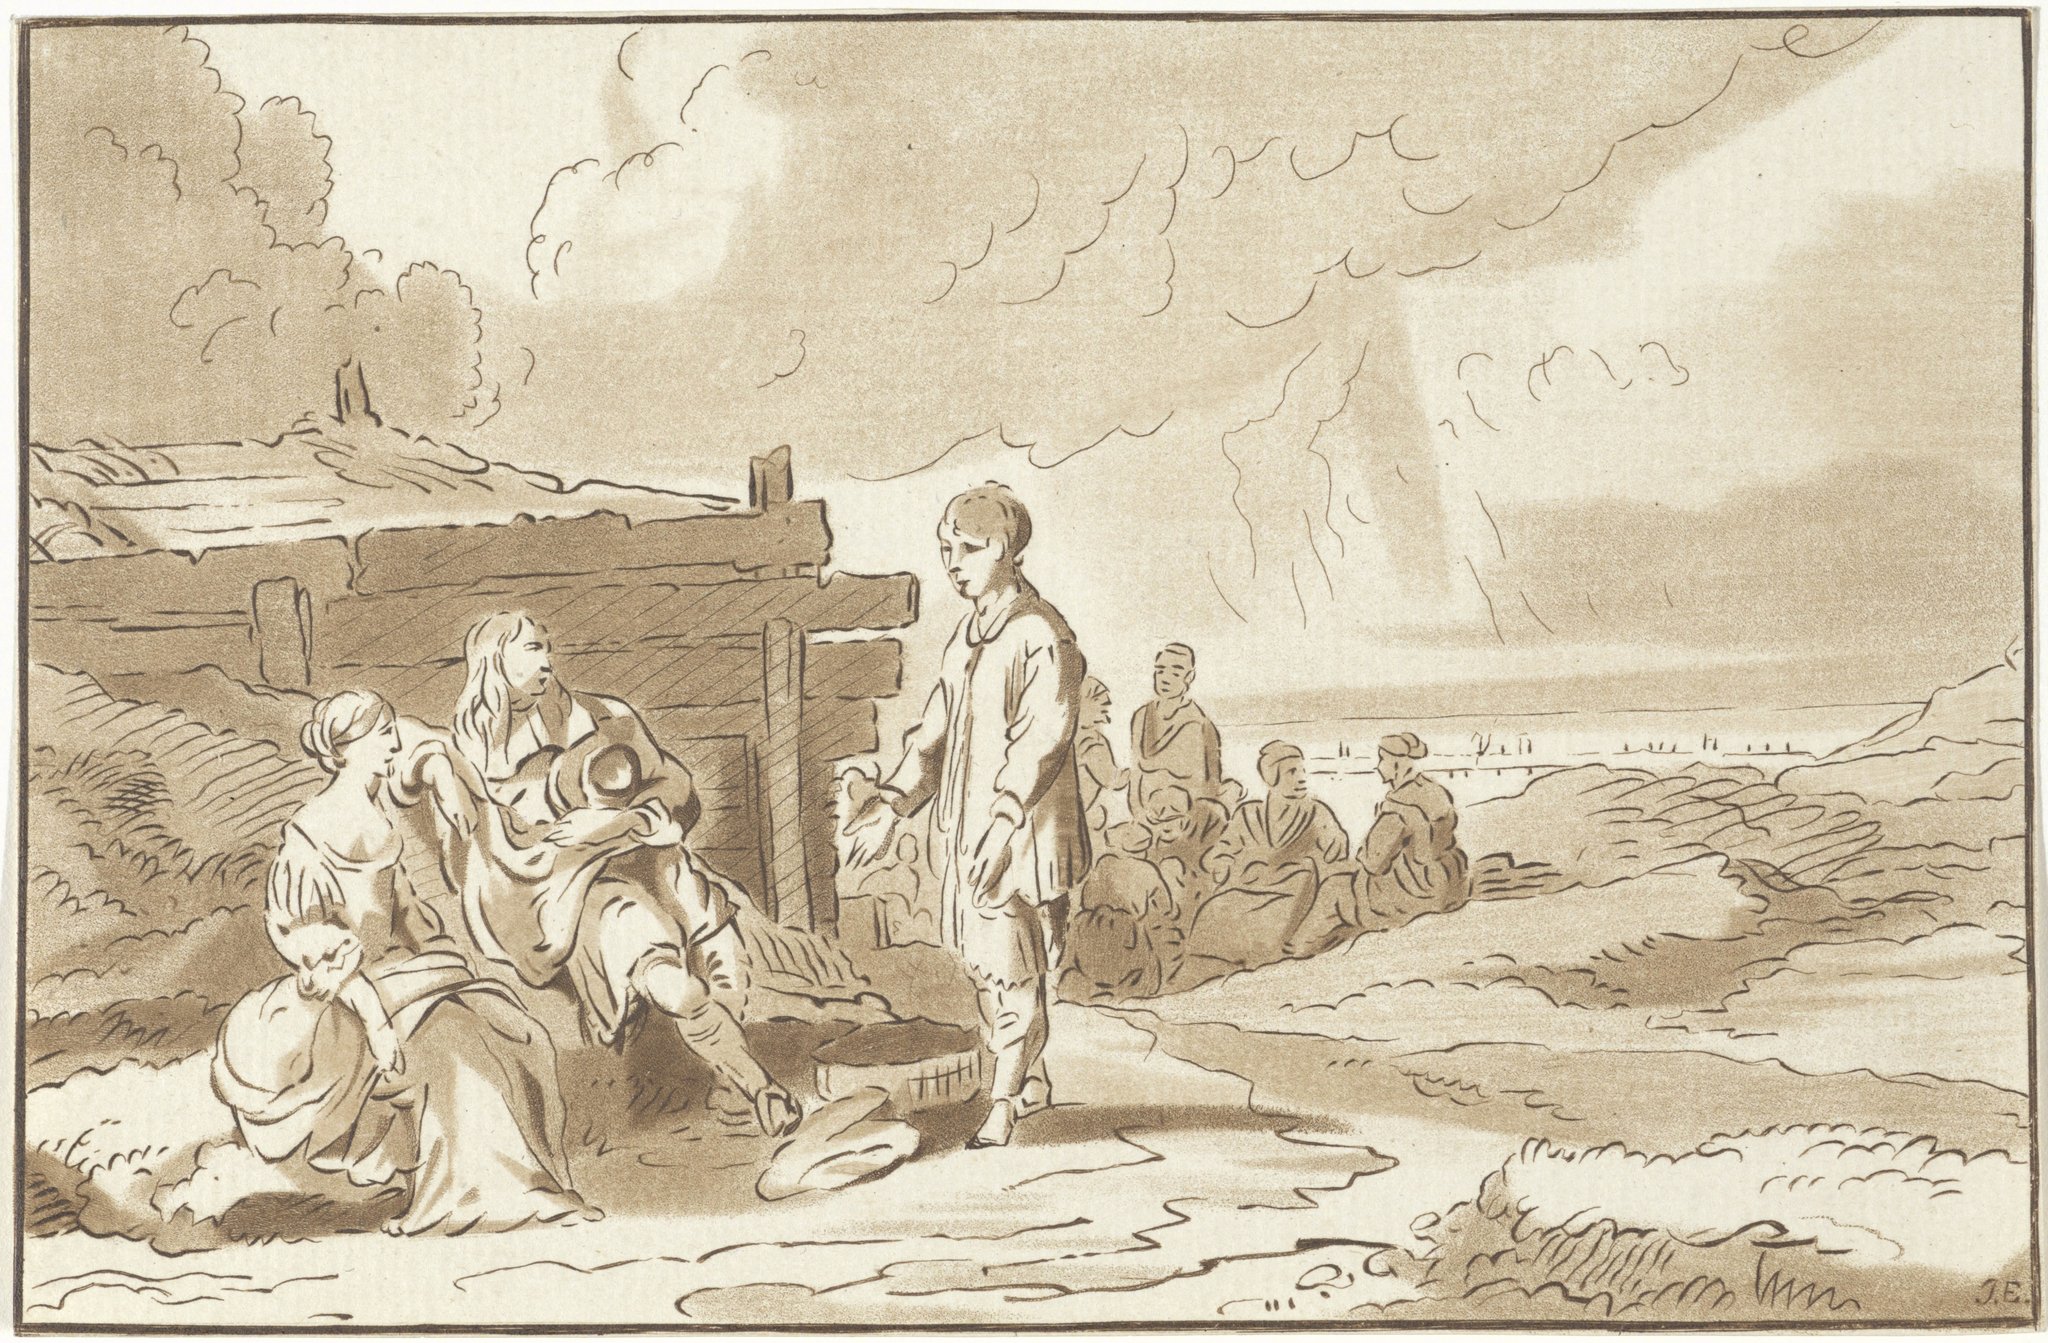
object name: print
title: Gezelschap in de duinen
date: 1767-1780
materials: paper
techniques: etching, rocker stamped, roulette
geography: netherlands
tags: recreation in the dunes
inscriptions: collector's mark: Lugt 240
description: Bij een schutting zitten een man en een vrouw. Zij spreken met een jongen die bij hen staat. Op de achtergrond zit een andere groep mensen in de duinen.